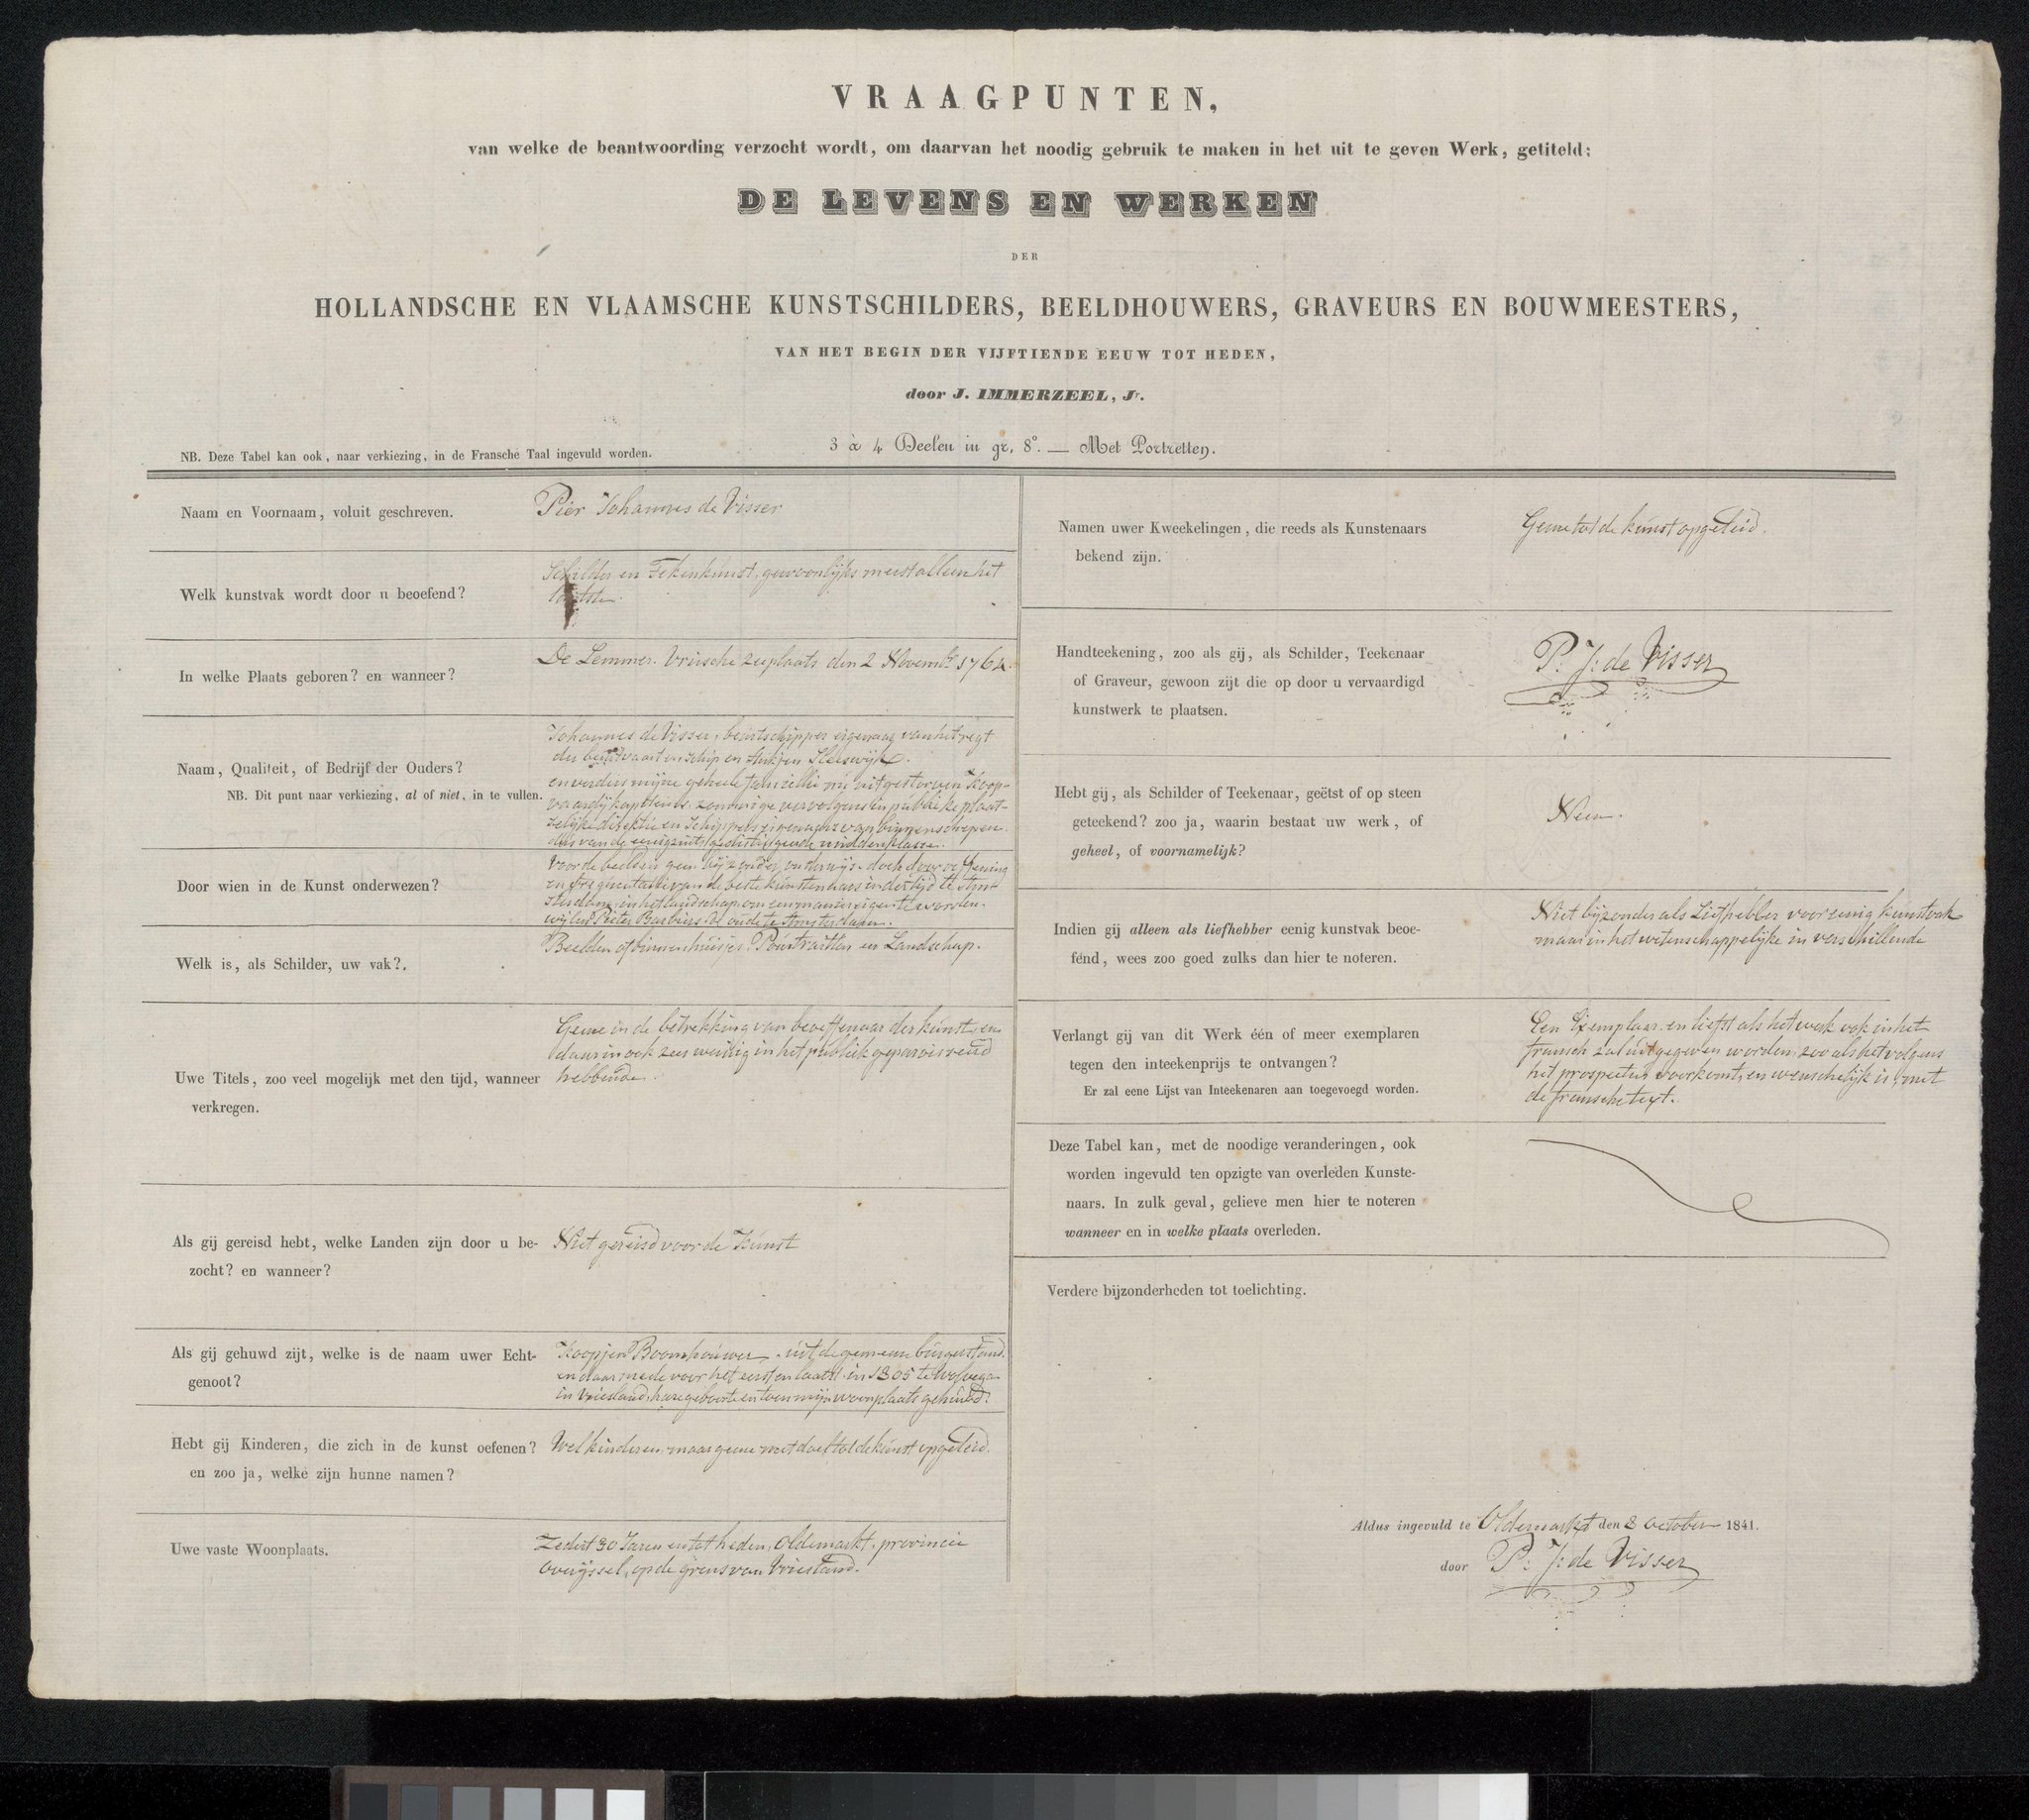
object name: manuscript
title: Enquêteformulier ingevuld door Pier Johannes de Visser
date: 1841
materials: ink, paper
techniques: pen, printing, writing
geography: oldemarkt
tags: draughtsman, pier johannes de visser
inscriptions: inscription: ‘Vraagpunten,/ van welke de beantwoording verzocht wordt, om daarvan het noodig gebruik te maken in het uit te geven Werk, getiteld: De levens en werken/ der Hollandsche en Vlaamsche kunstschilders, beeldhouwers,/ graveurs en bouwmeesters, van het begin der vijftiende eeuw tot heden/ door J. Immerzeel, Jr.’, watermark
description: Opgenomen in: Immerzeel, J. Jr., De levens en werken der Hollandsche en Vlaamsche kunstschilders, beeldhouwers, graveurs en bouwmeesters, van het begin der vijftiende eeuw tot heden, Amsterdam: J.C. van Kesteren, 1842-1843.